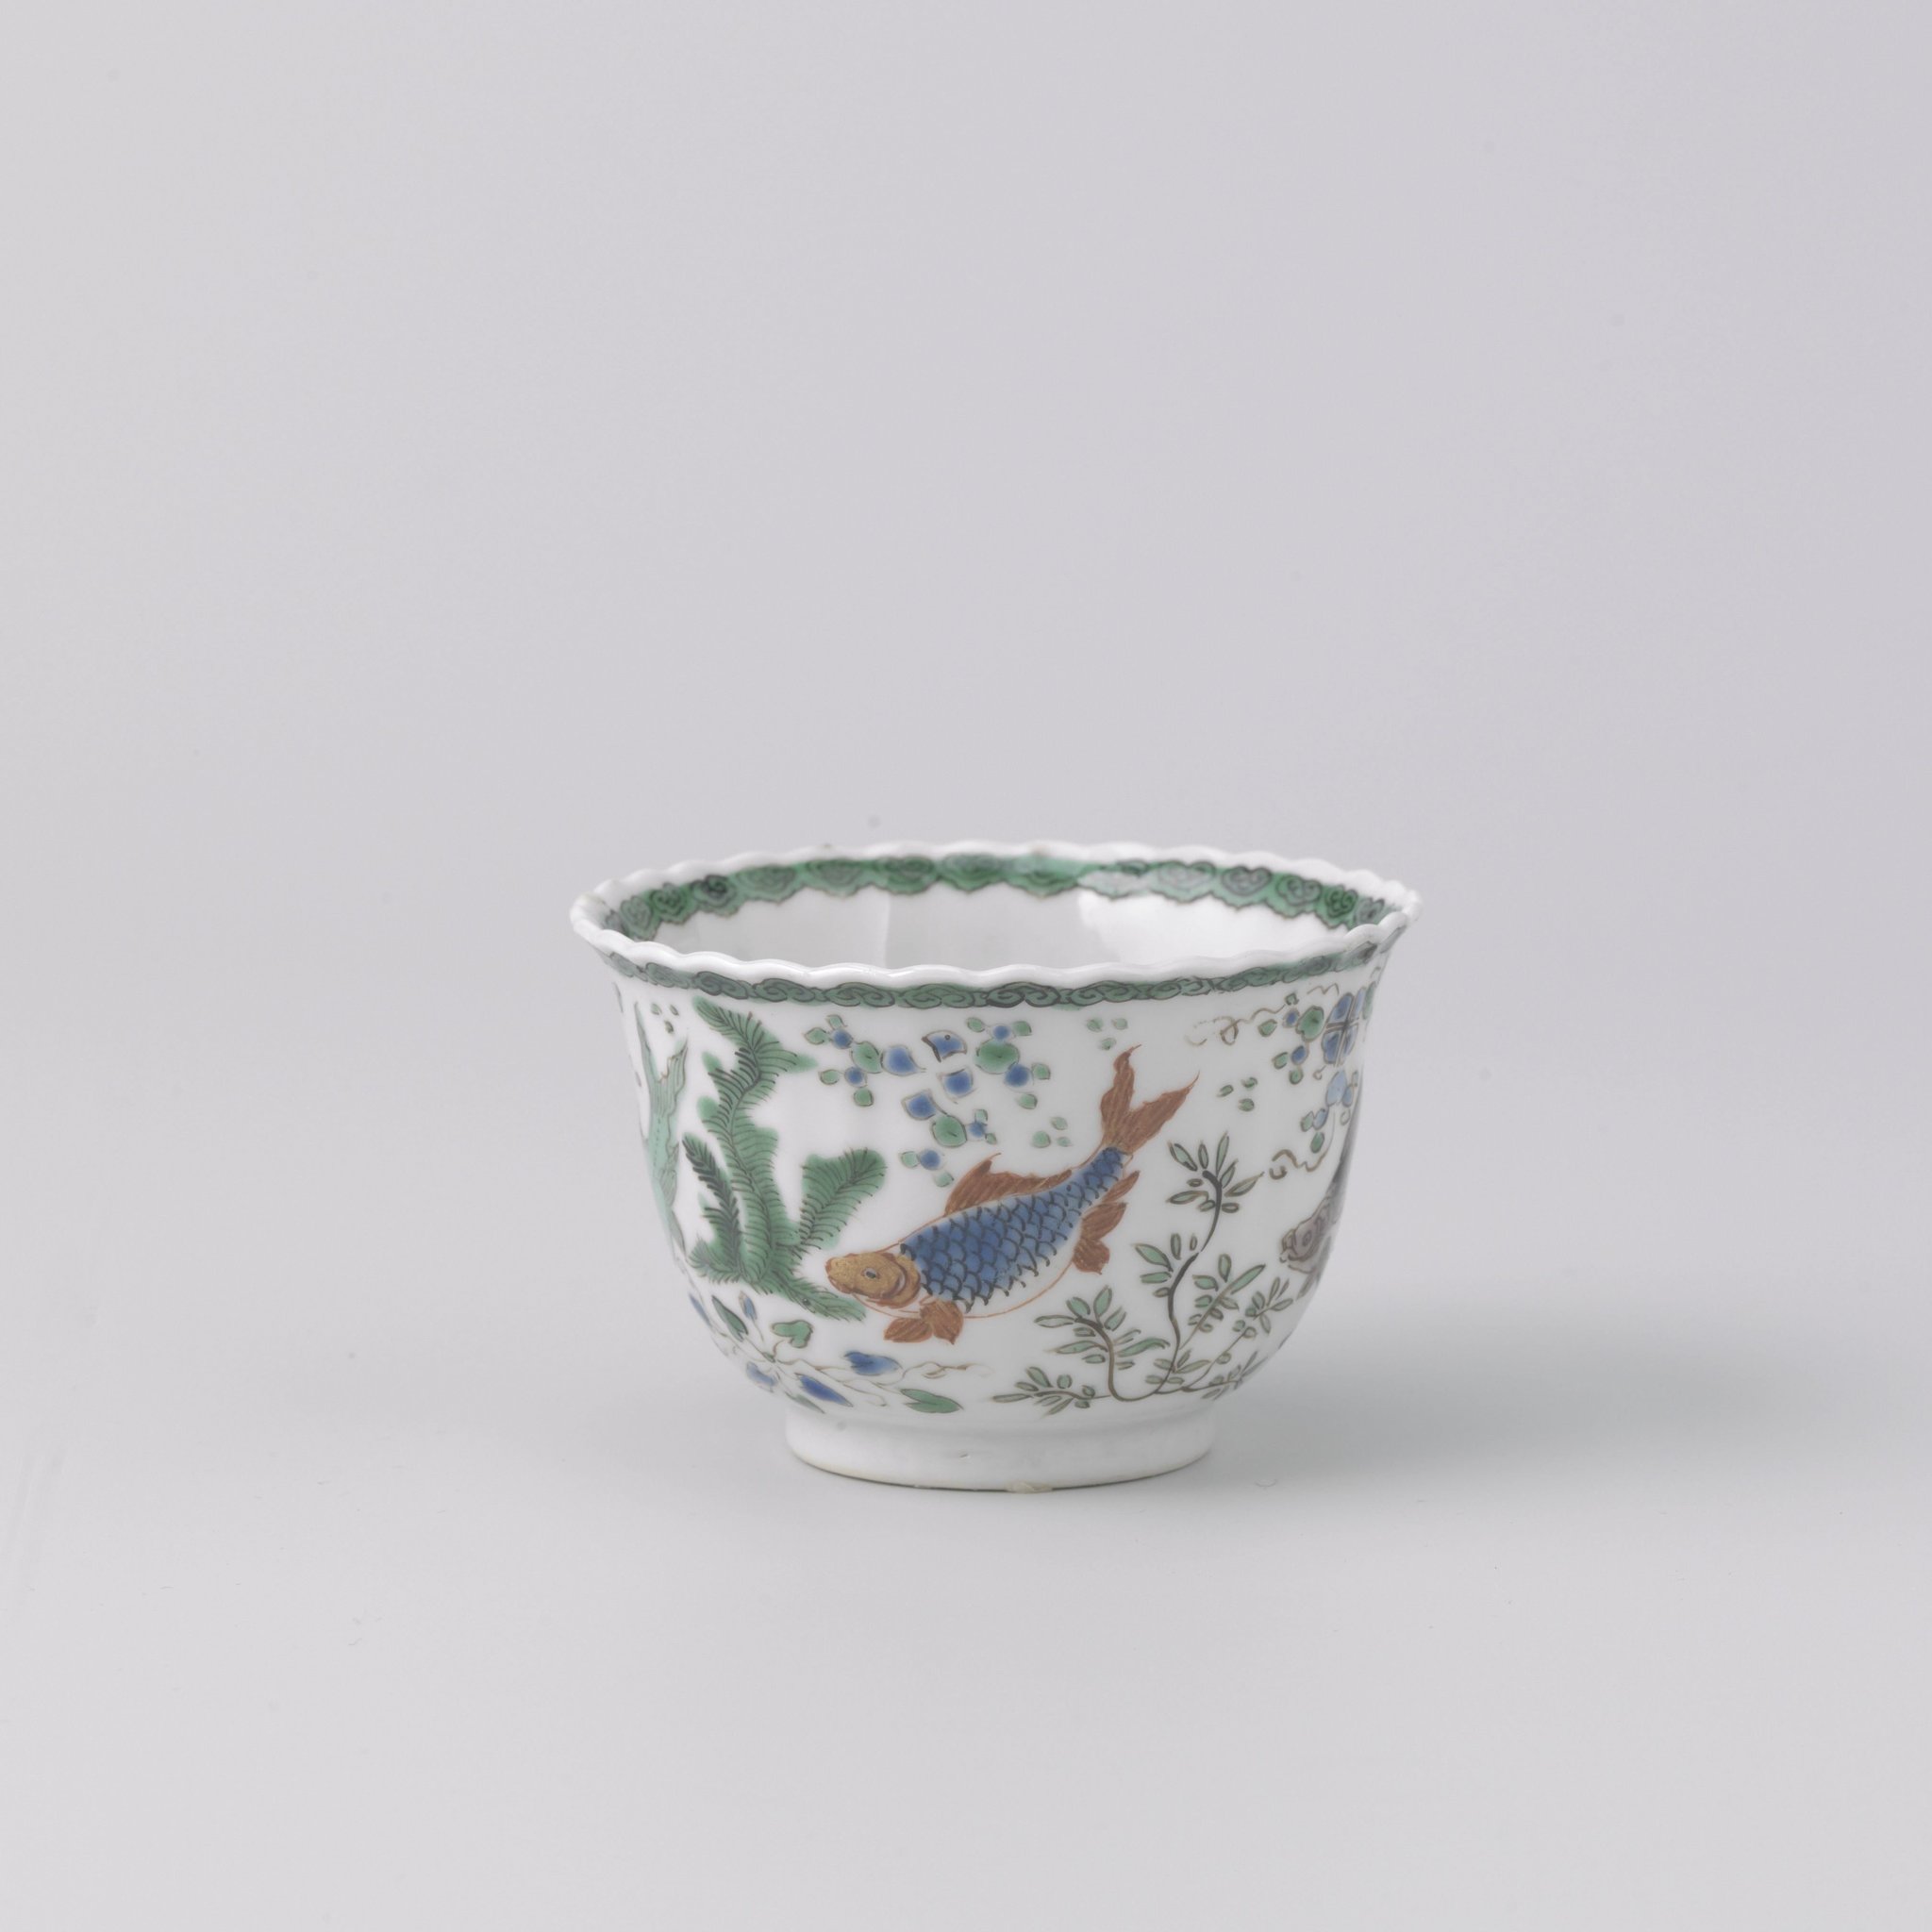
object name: cup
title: Cup with fish between water plants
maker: Anonymous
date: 1700-1724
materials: cobalt, glaze, gold, paint, porcelain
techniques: firing, turning, vitrification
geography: china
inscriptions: mark: ‘玉’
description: Kop van porselein met geribde wand en gelobde rand, beschilderd in onderglazuur blauw en op het glazuur blauw, rood, groen, geel, aubergine, zwart en goud. De buitenzijde van de kop met vier vissen tussen waterplanten, de rand met een band ruyi-motief; op de bodem een vis en de binnenzijde met vier vissen in ijzerrood, de rand met een band ruyi-motief. Gemerkt op de onderzijde met 'Yù', jade, in een dubbele cirkel. Famille verte.